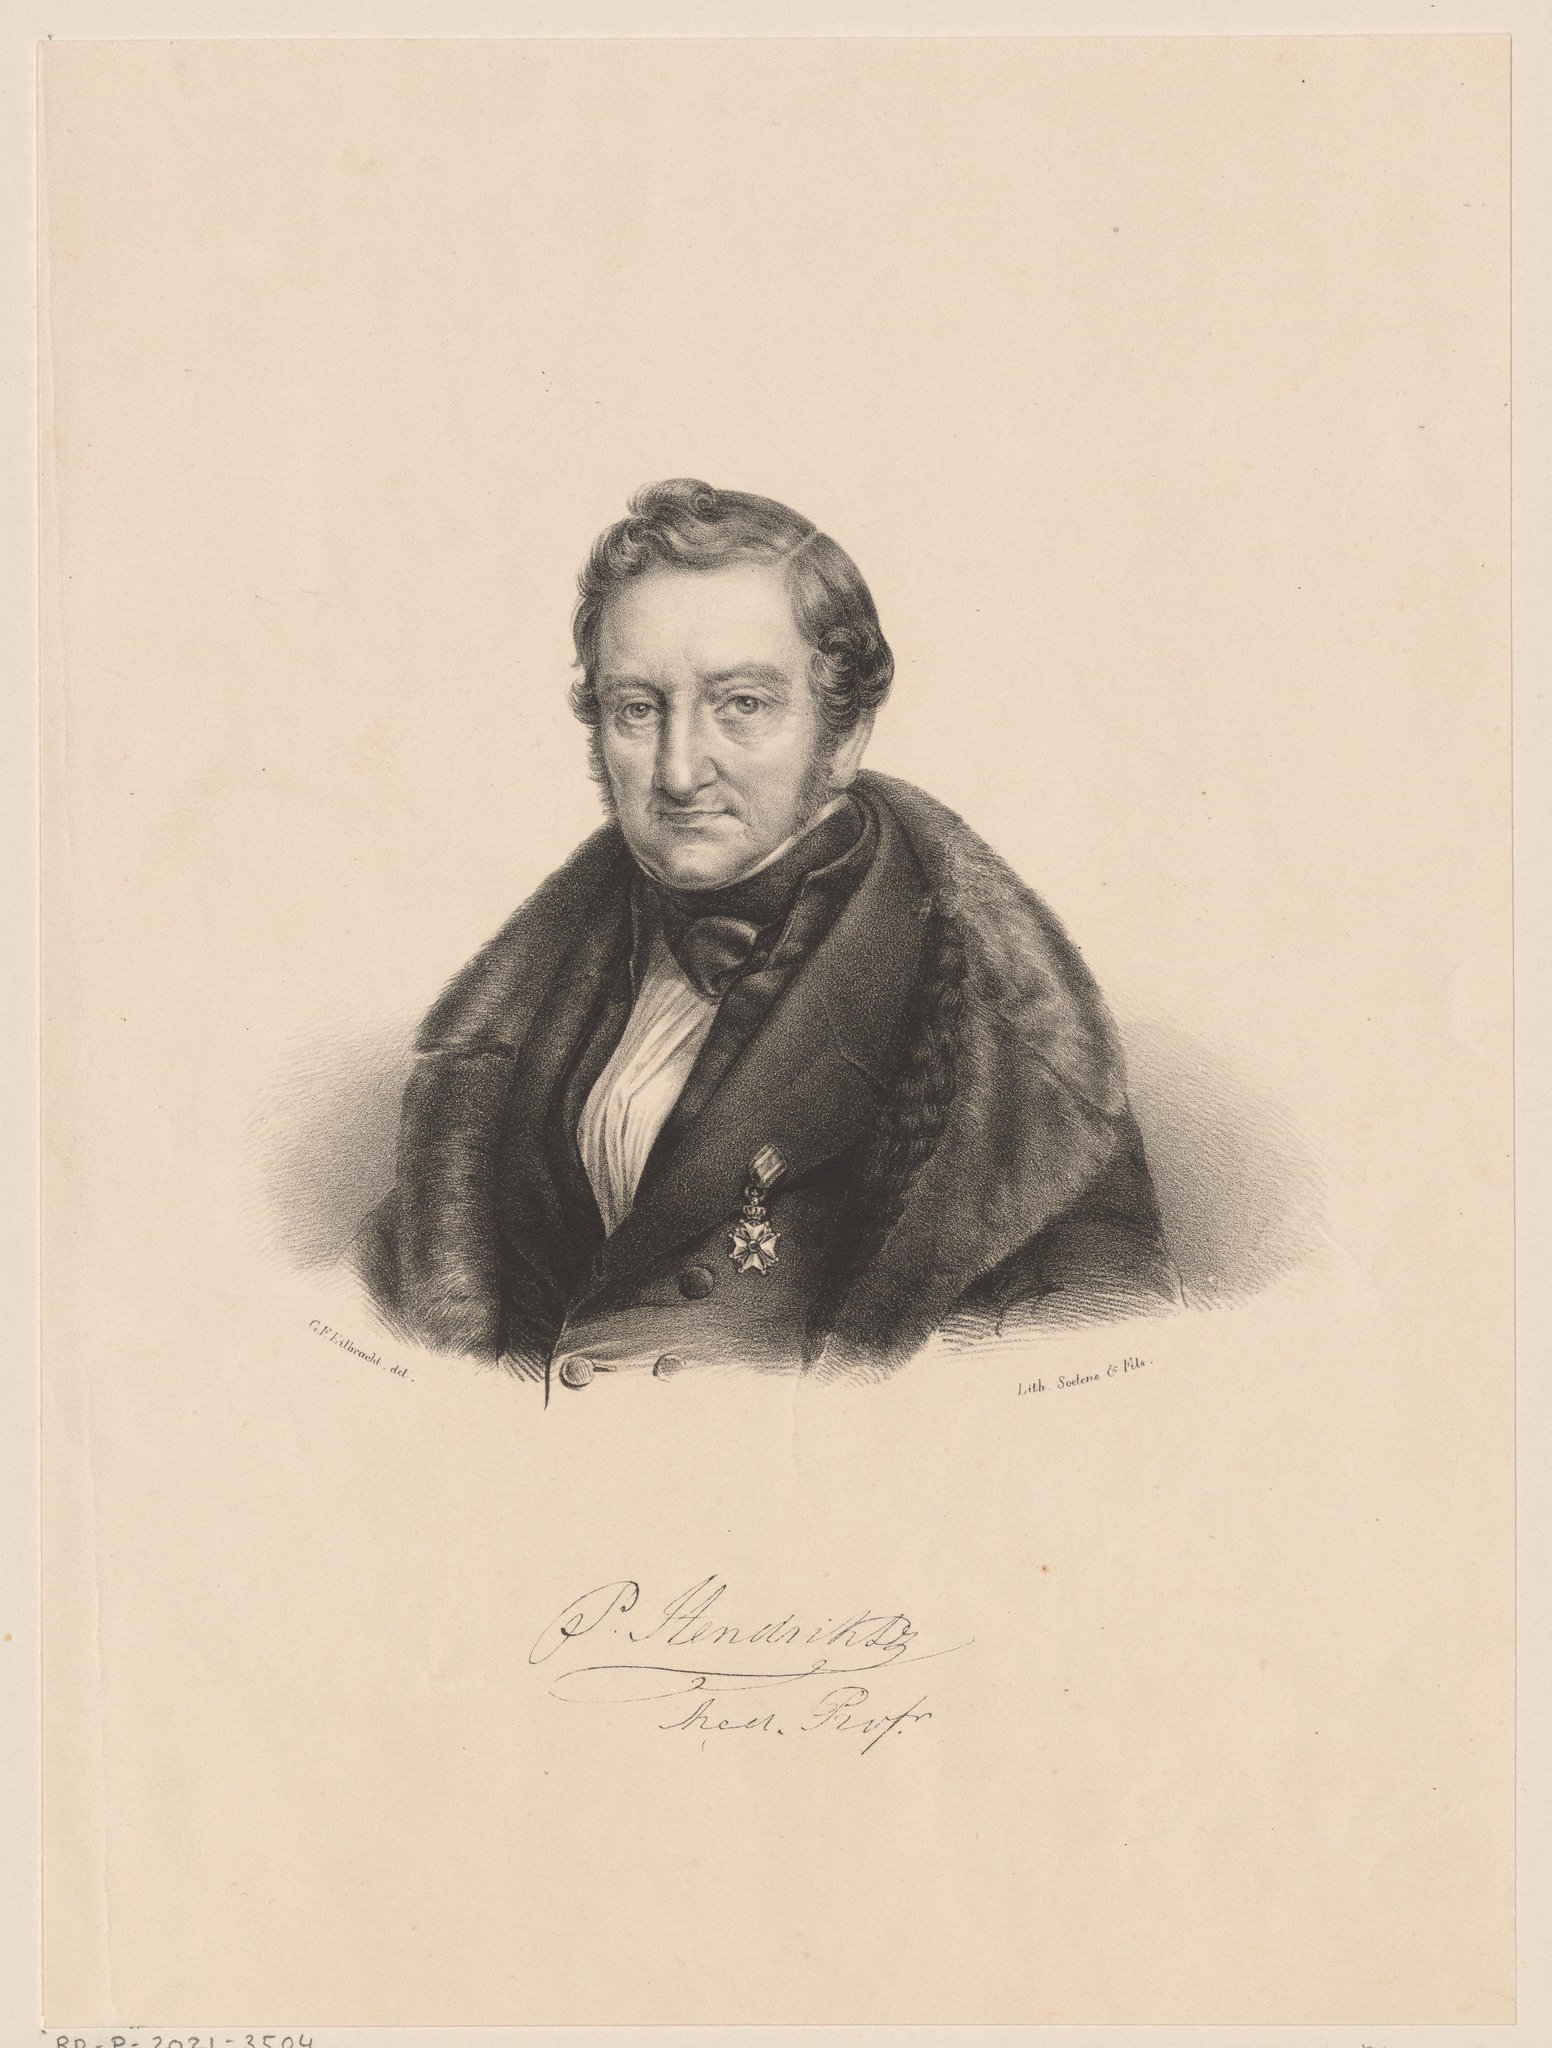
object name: print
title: Portret van Pieter Hendriksz.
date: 1837-1840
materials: paper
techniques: lithograph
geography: the hague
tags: enkhuizen, voorburg, historical persons, physician, doctor